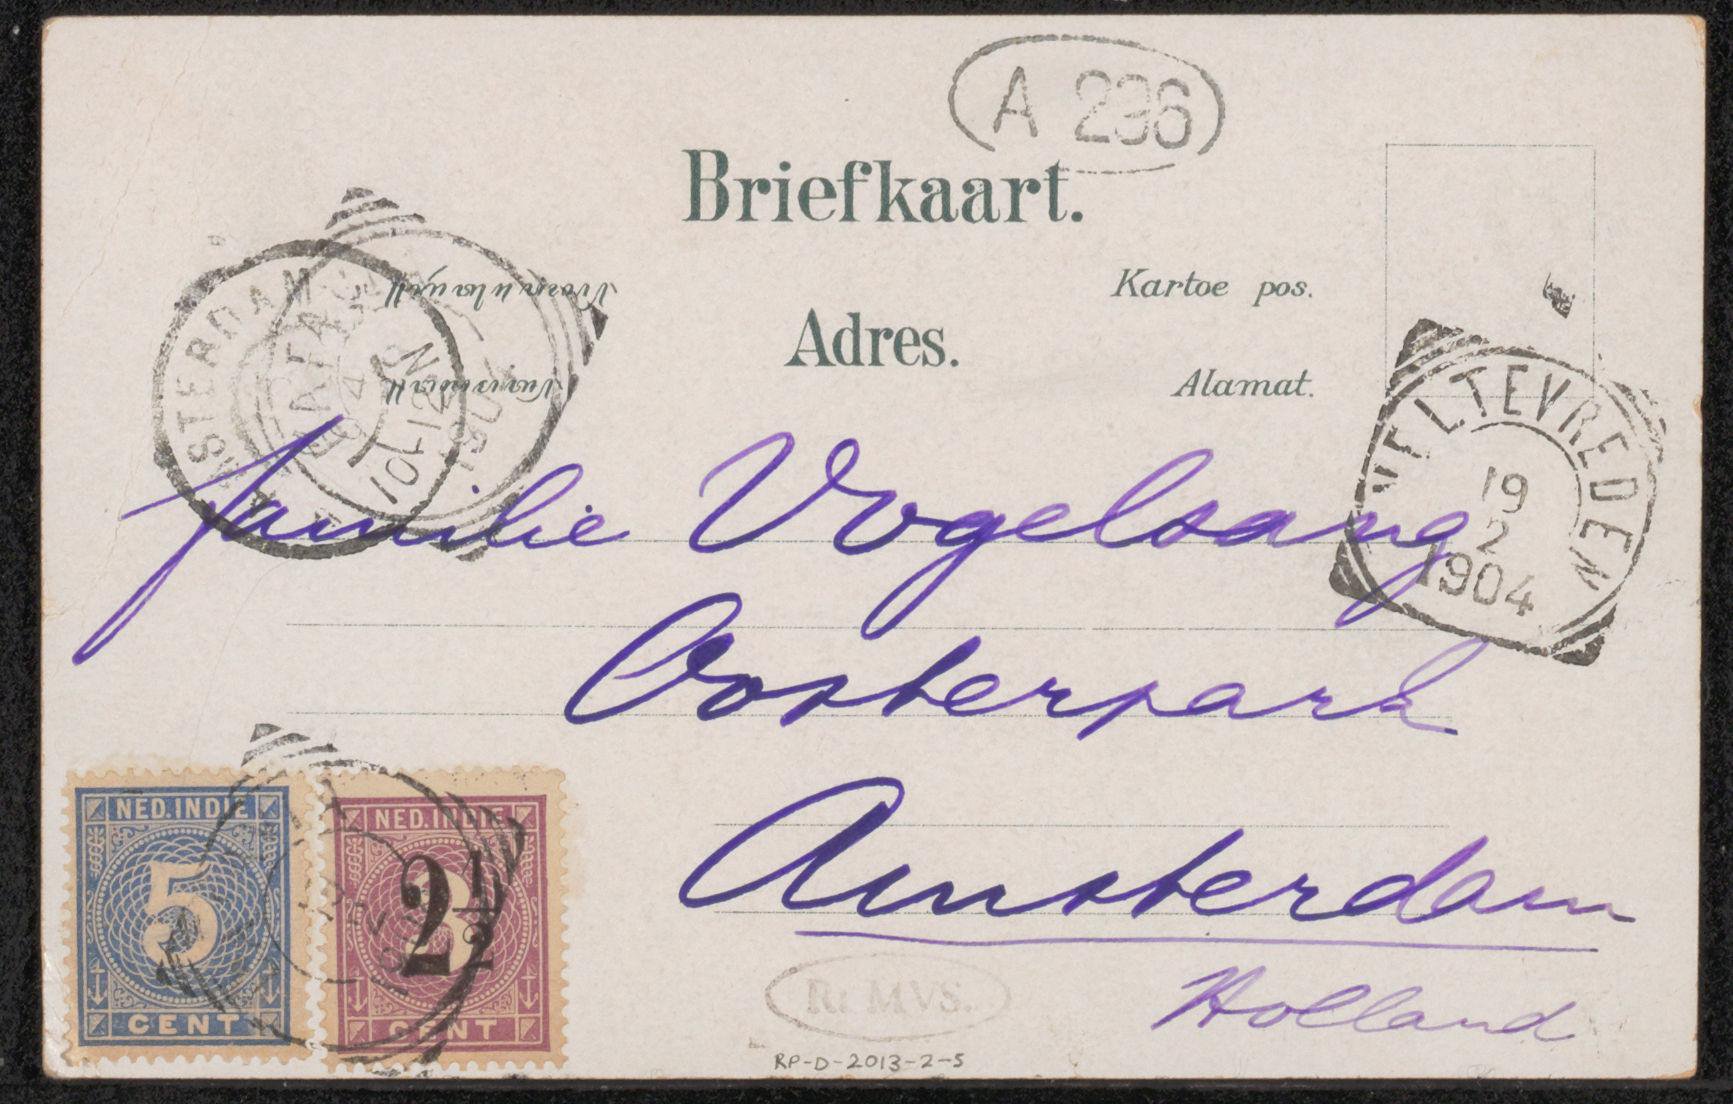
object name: ansichtkaart, prentbriefkaart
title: Prentbriefkaart aan Willem Vogelsang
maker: Anonymous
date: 1904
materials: cardboard, ink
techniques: pen, writing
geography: batavia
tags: leiden, utrecht, draughtsman, willem vogelsang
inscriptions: collector's mark: Lugt 2228